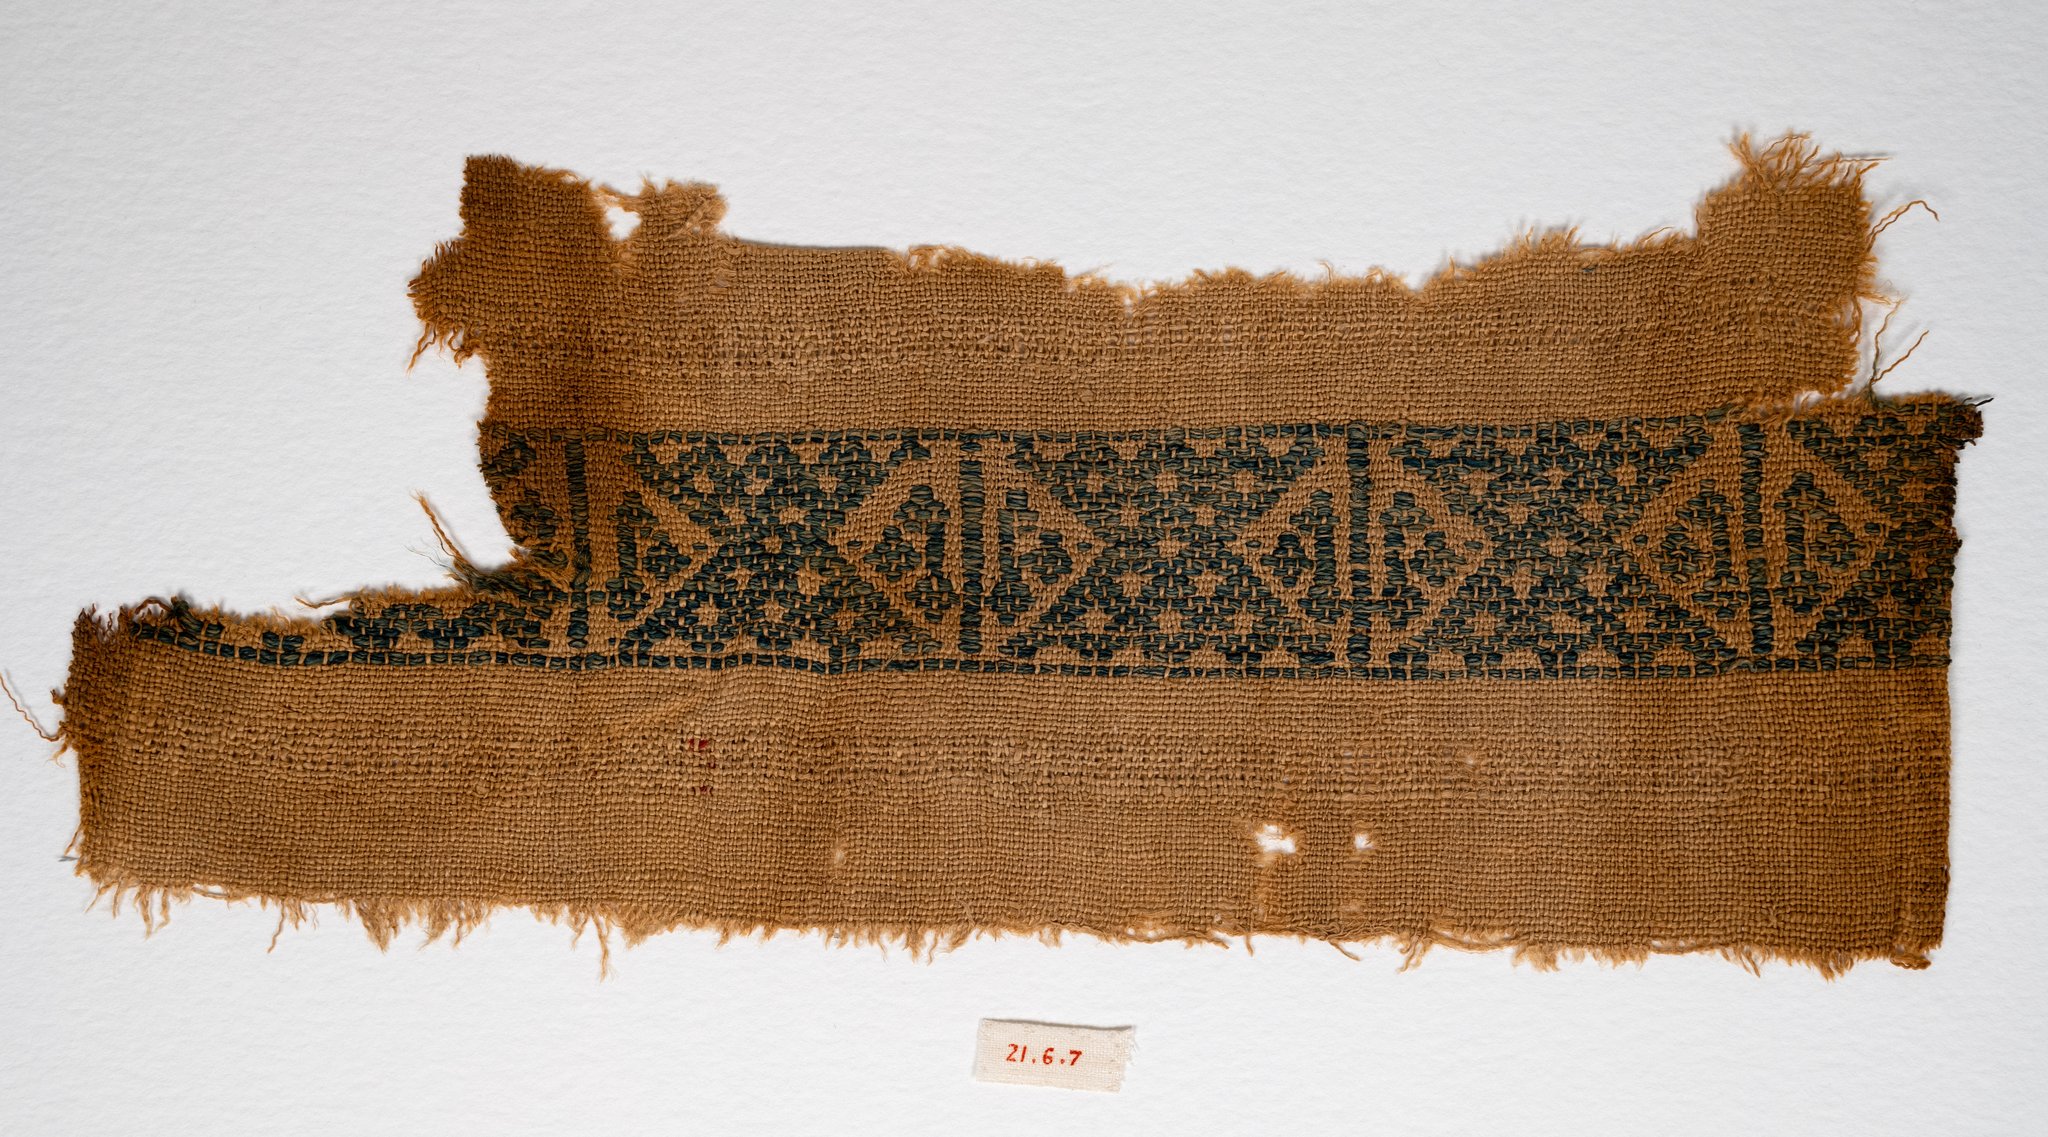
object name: textile fragment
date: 1001-1200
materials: linen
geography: egypt